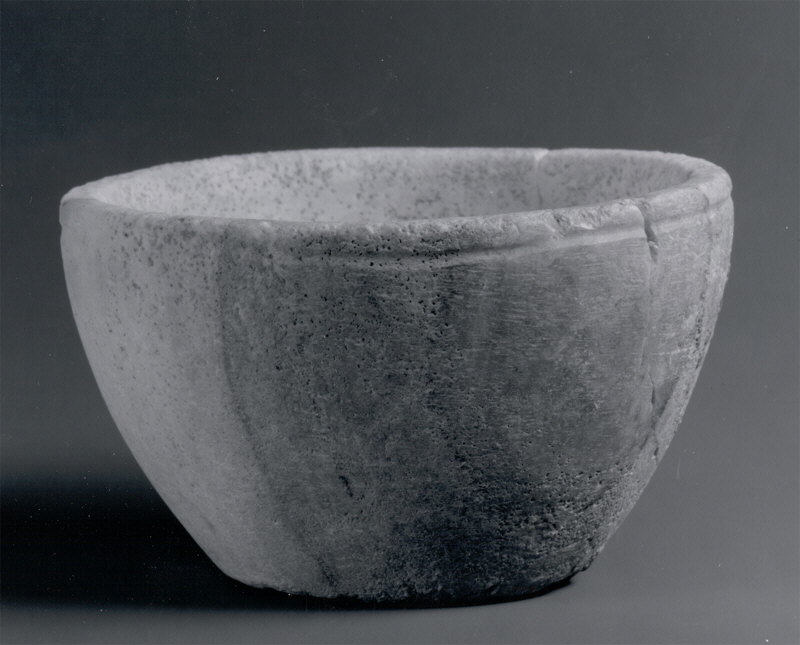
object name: bowl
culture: bactria-margiana archaeological complex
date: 2333-1668 BCE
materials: marble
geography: bactria-margiana